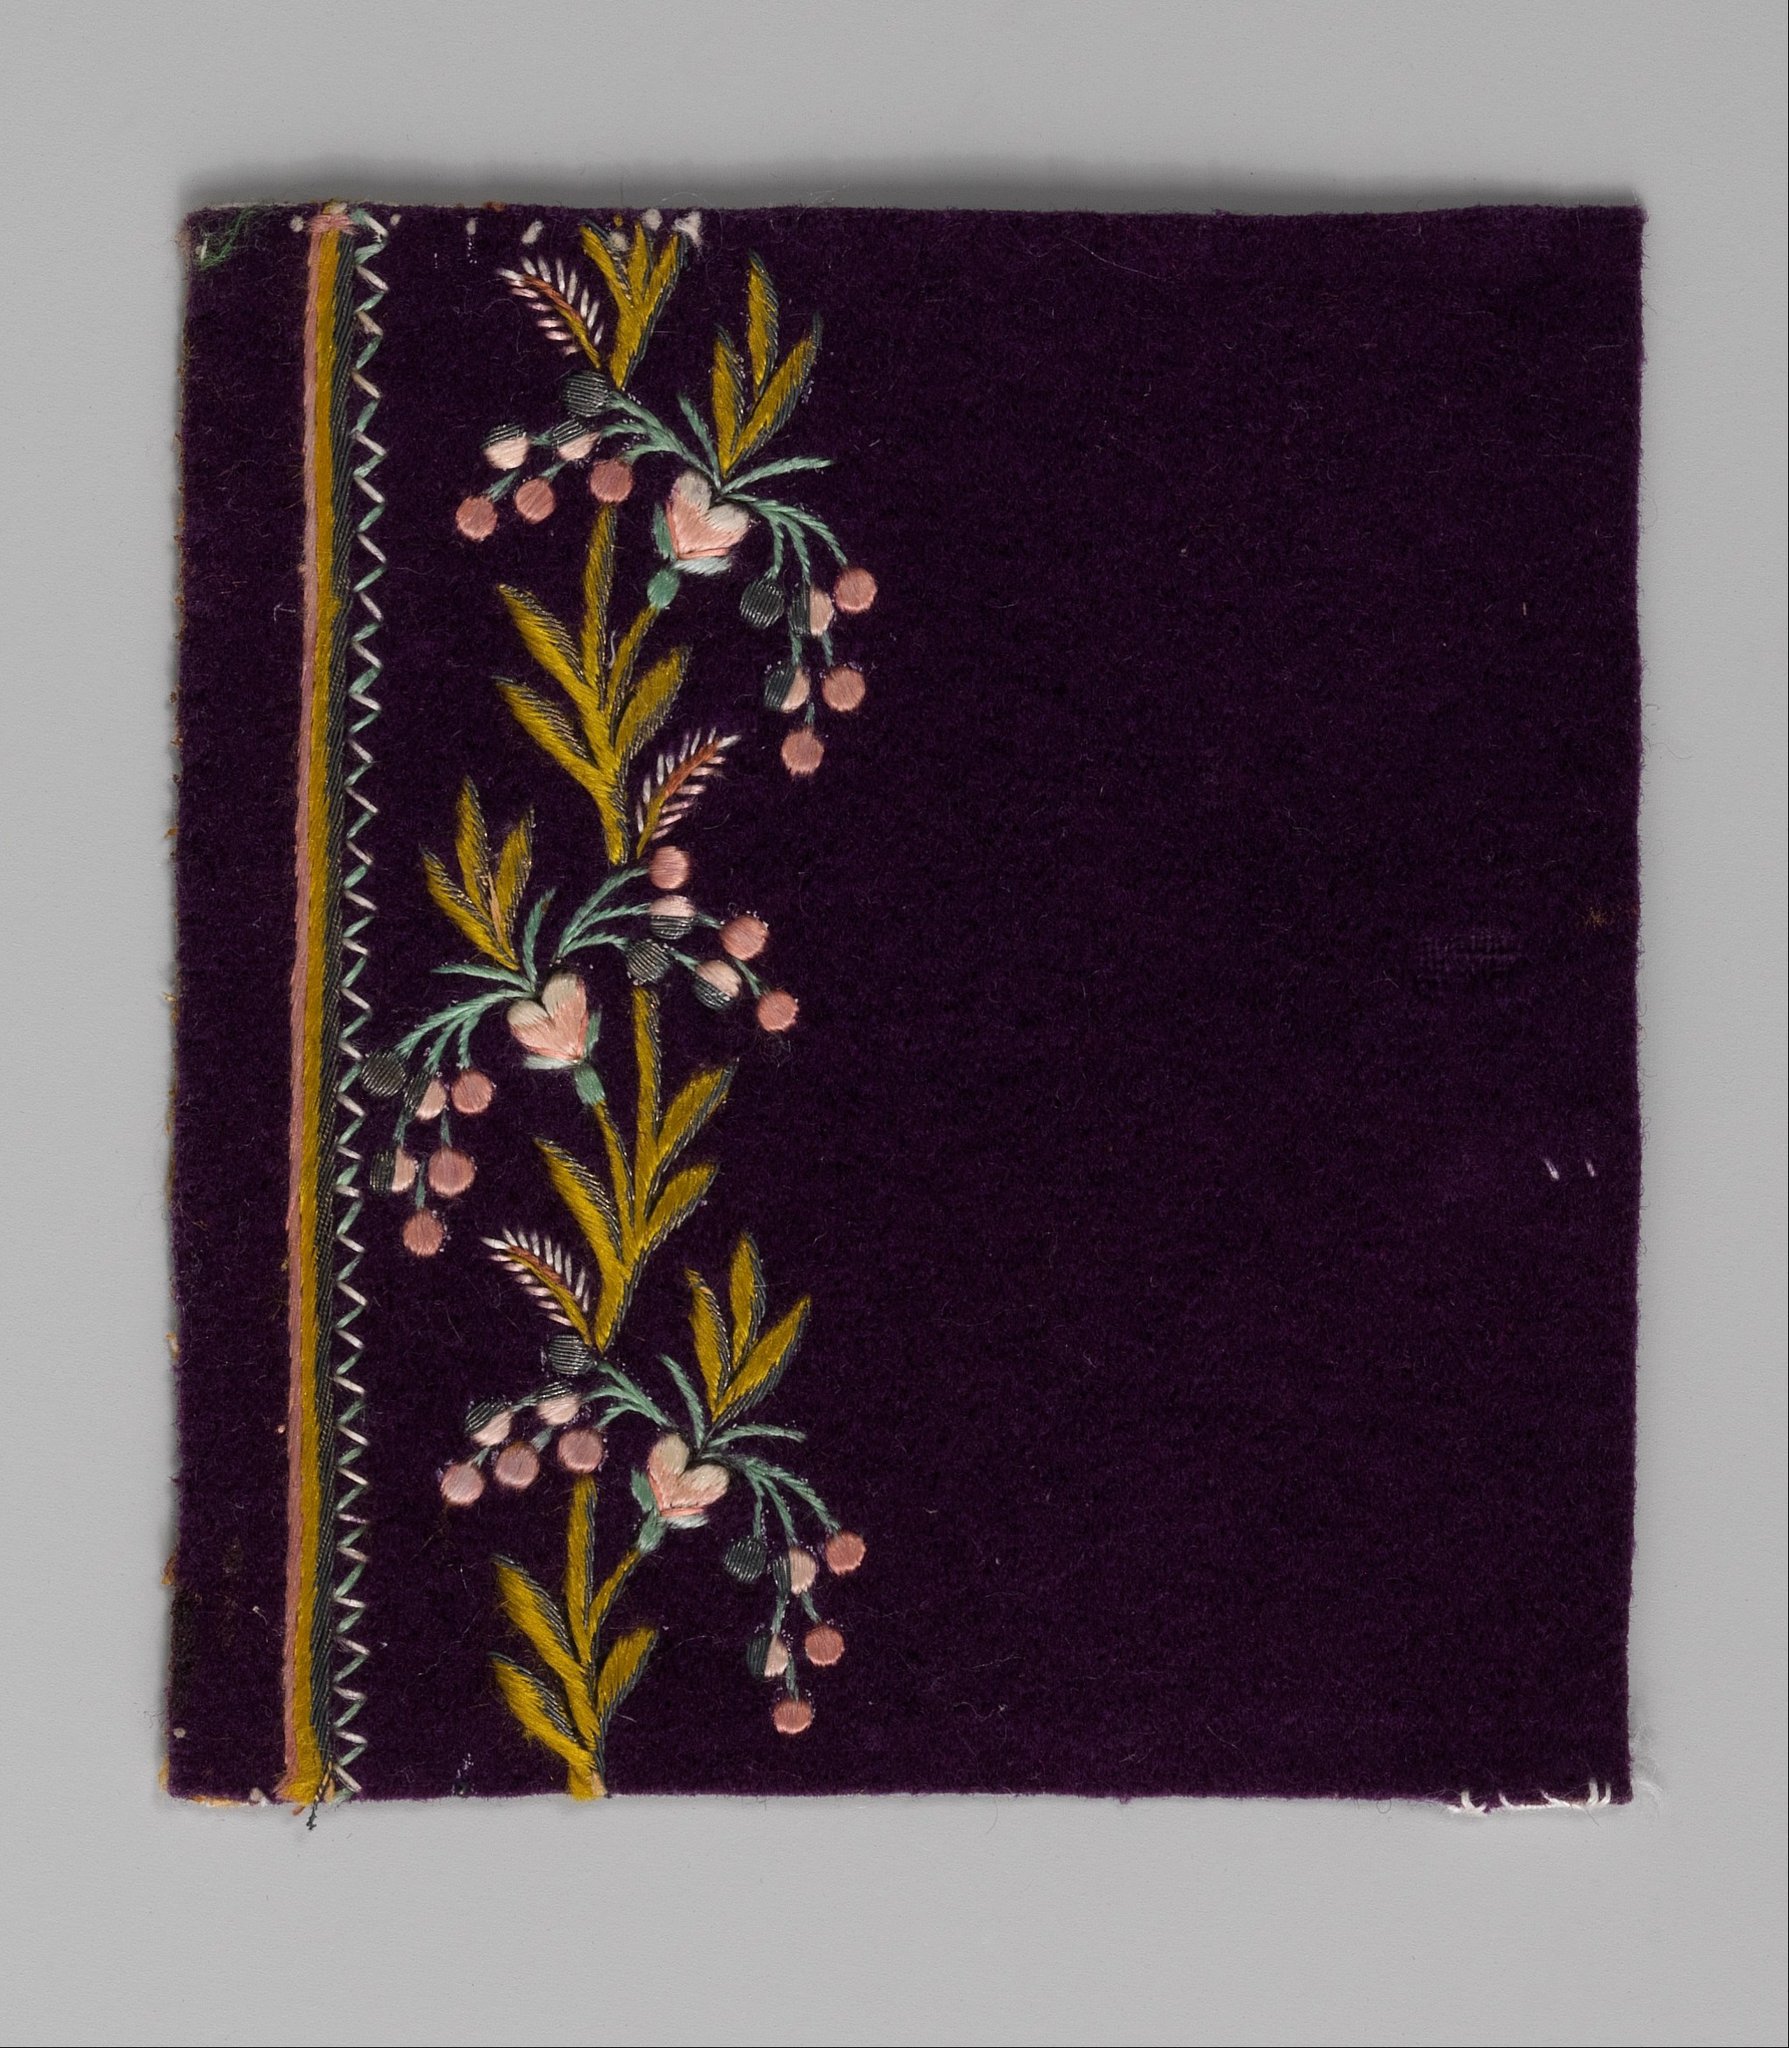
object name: sample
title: Embroidery sample for a man’s suit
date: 1800-1815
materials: metal thread, silk, velvet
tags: flowers